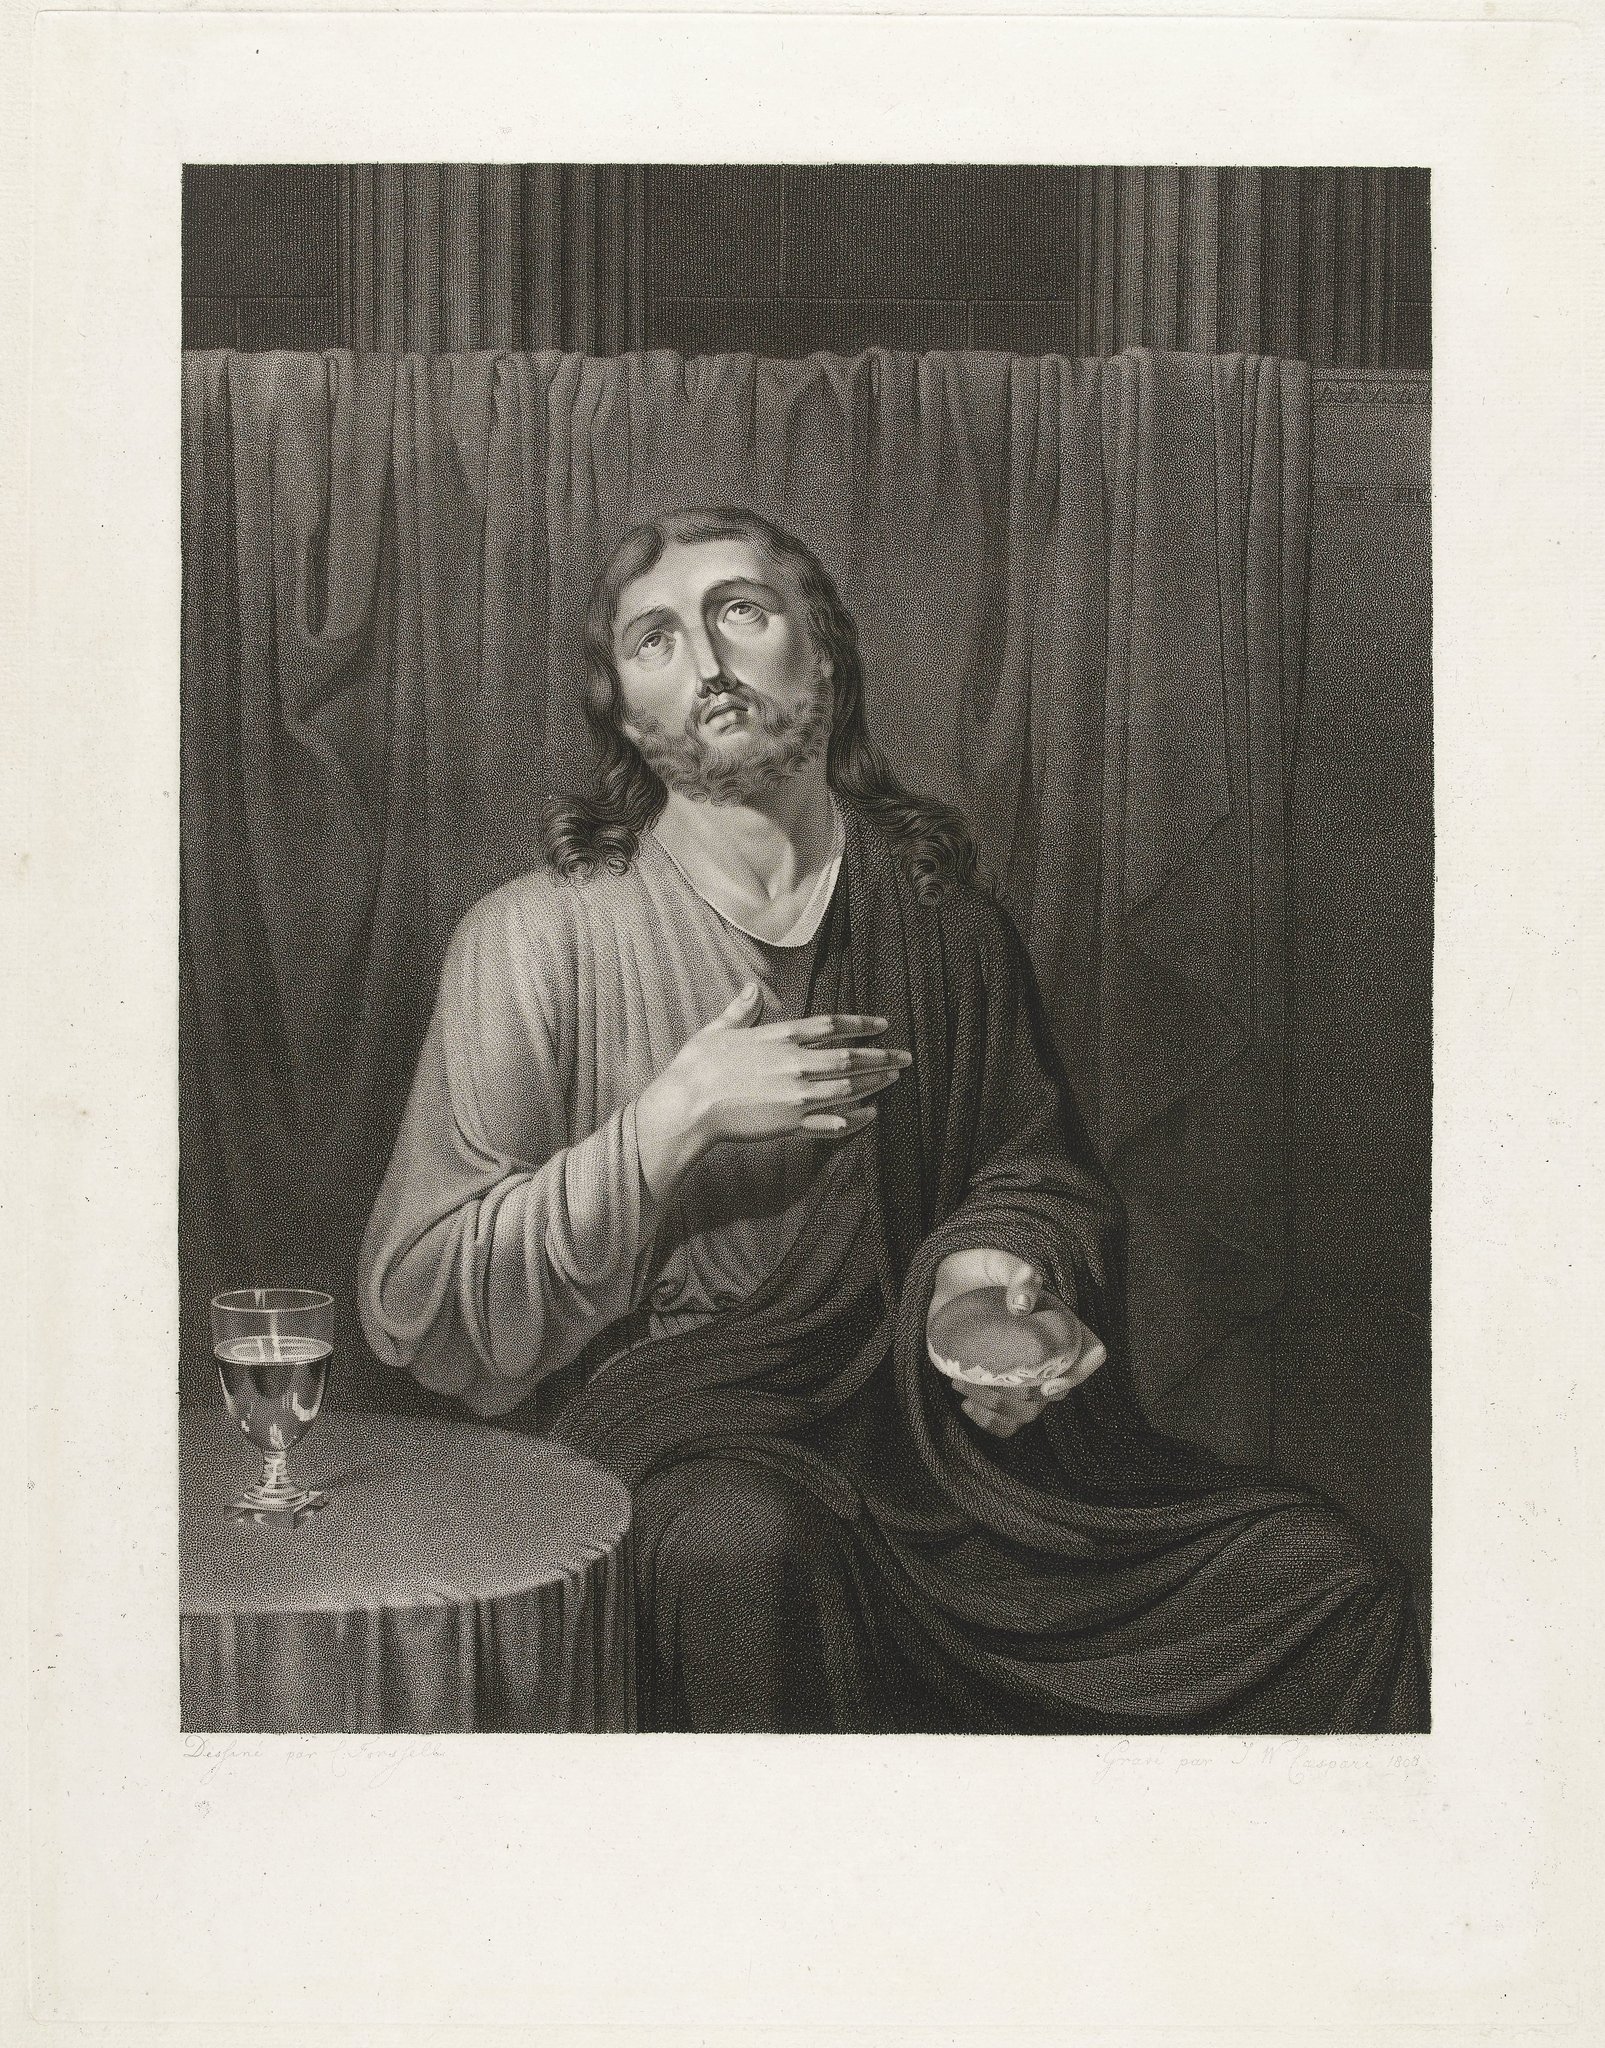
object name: print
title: Christus bij het Laatste Avondmaal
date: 1808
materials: paper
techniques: etching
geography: amsterdam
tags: institution of the eucharist, i.e. christ showing or blessing bread (host) and/or wine (matthew 26:26-27; mark 14:22-23; luke 22:19-20; john 13:26; 1 corinthians 11:23-25)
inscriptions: collector's mark: Lugt 2228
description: Christus zit op een bankje. In zijn linkerhand houdt hij een stuk brood. Zijn rechterhand rust op zijn borst. Volgens het Nieuwe Testament brak Christus het brood tijdens het Laatste Avondmaal met de woorden: ‘Neem, eet, dit is mijn lichaam' (Mattëus 26:26). Naast hem staat een tafeltje met een wijnkelk.